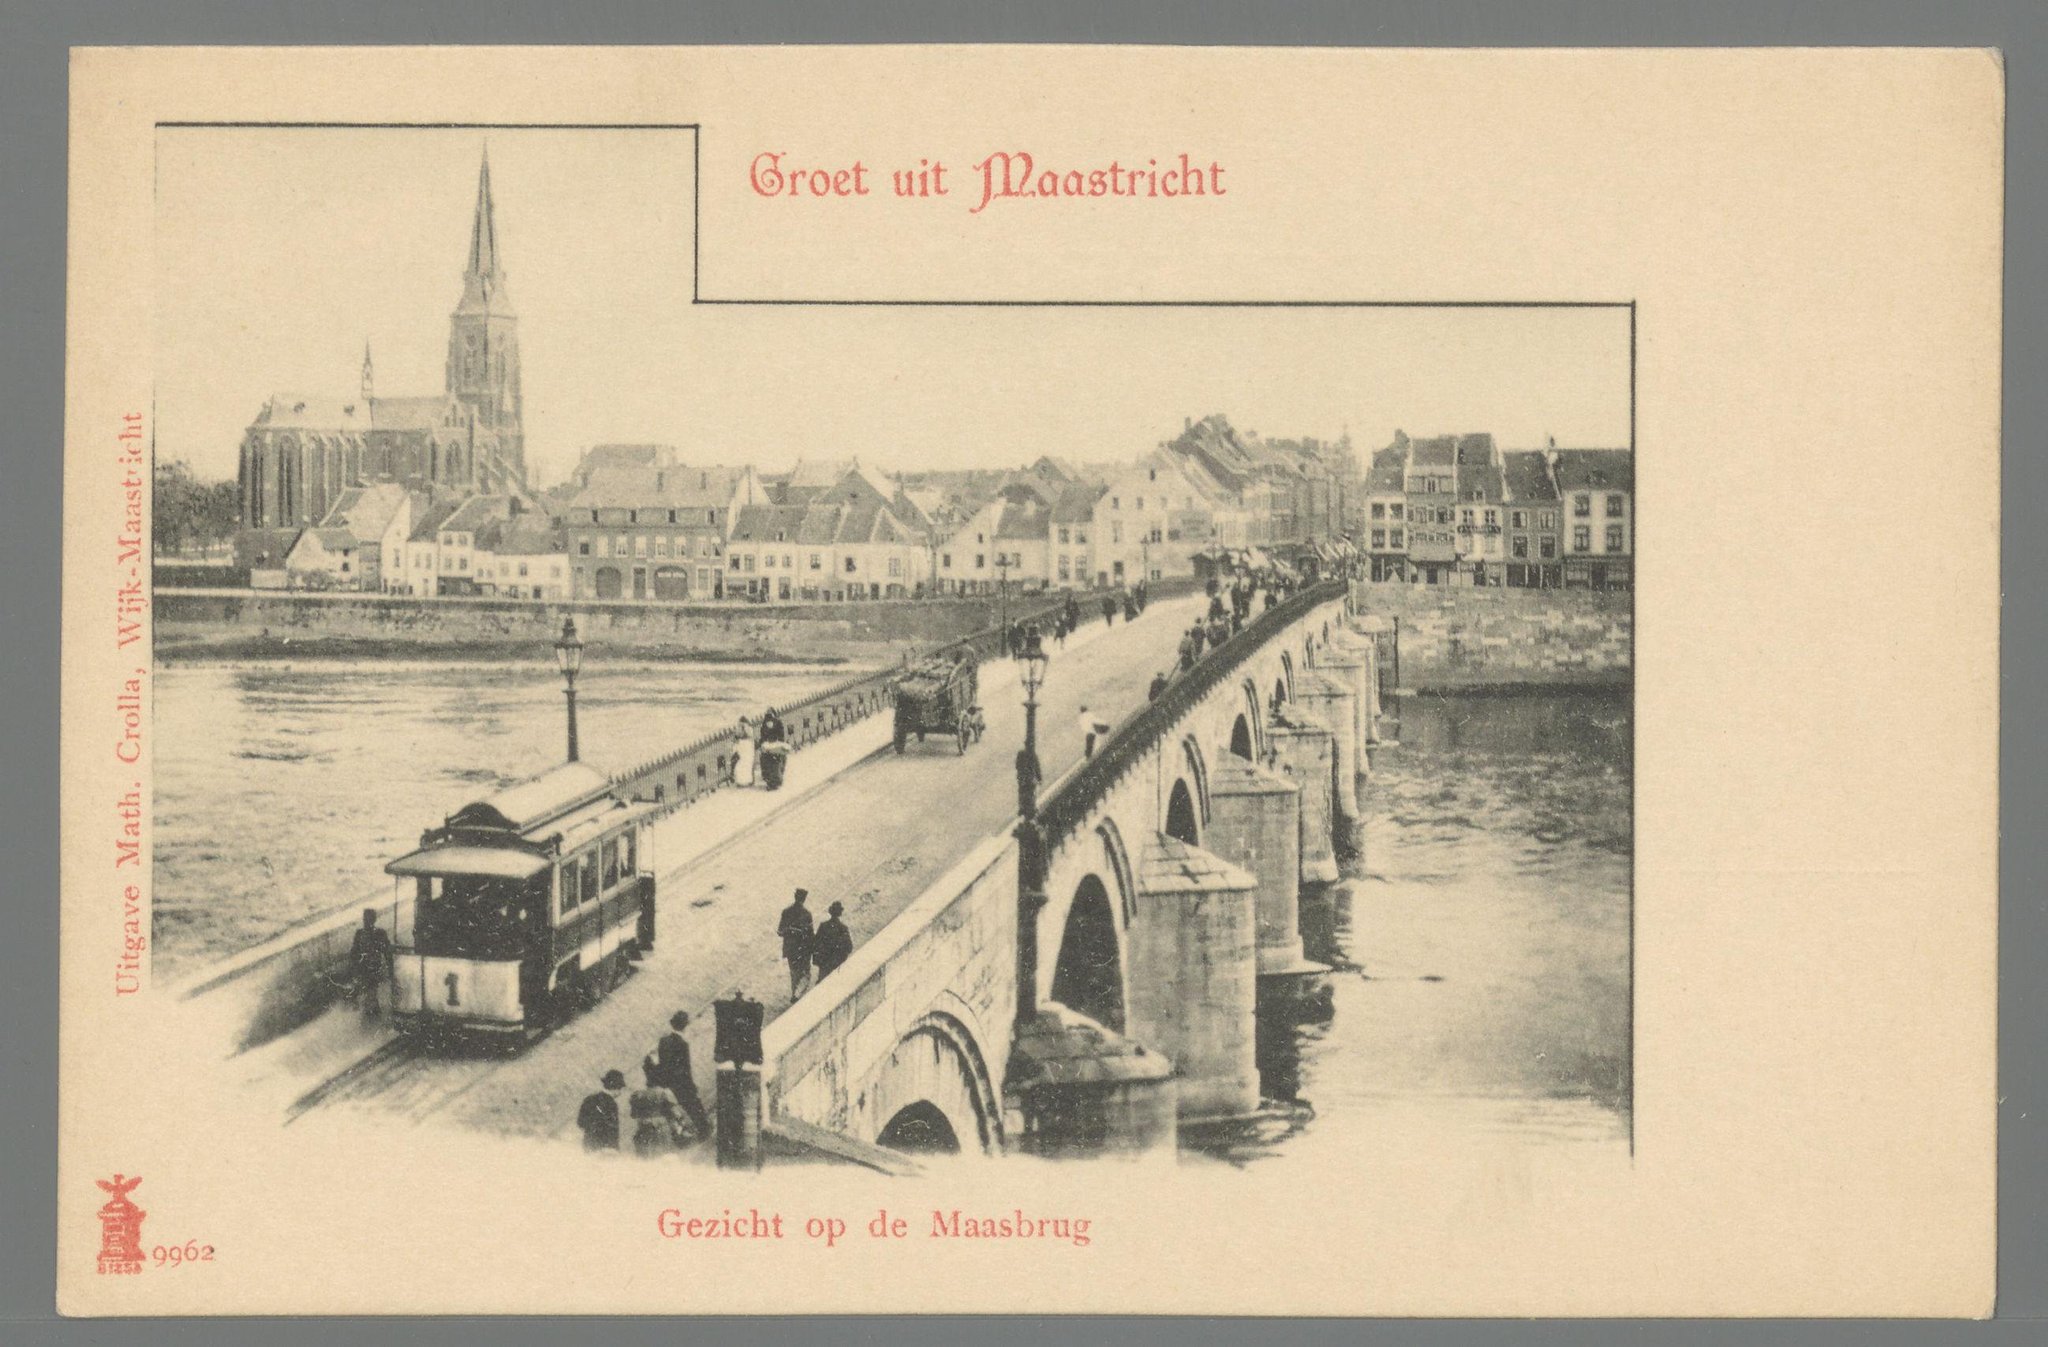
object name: ansichtkaart, prentbriefkaart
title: Groet uit Maastricht. Gezicht op de Maasbrug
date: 1897-1905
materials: cardboard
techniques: photograph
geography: wyck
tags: diligence, omnibus, horse-tram, city-view, and landscape with man-made constructions, customs, church (exterior), bridge in village across river, canal, etc.